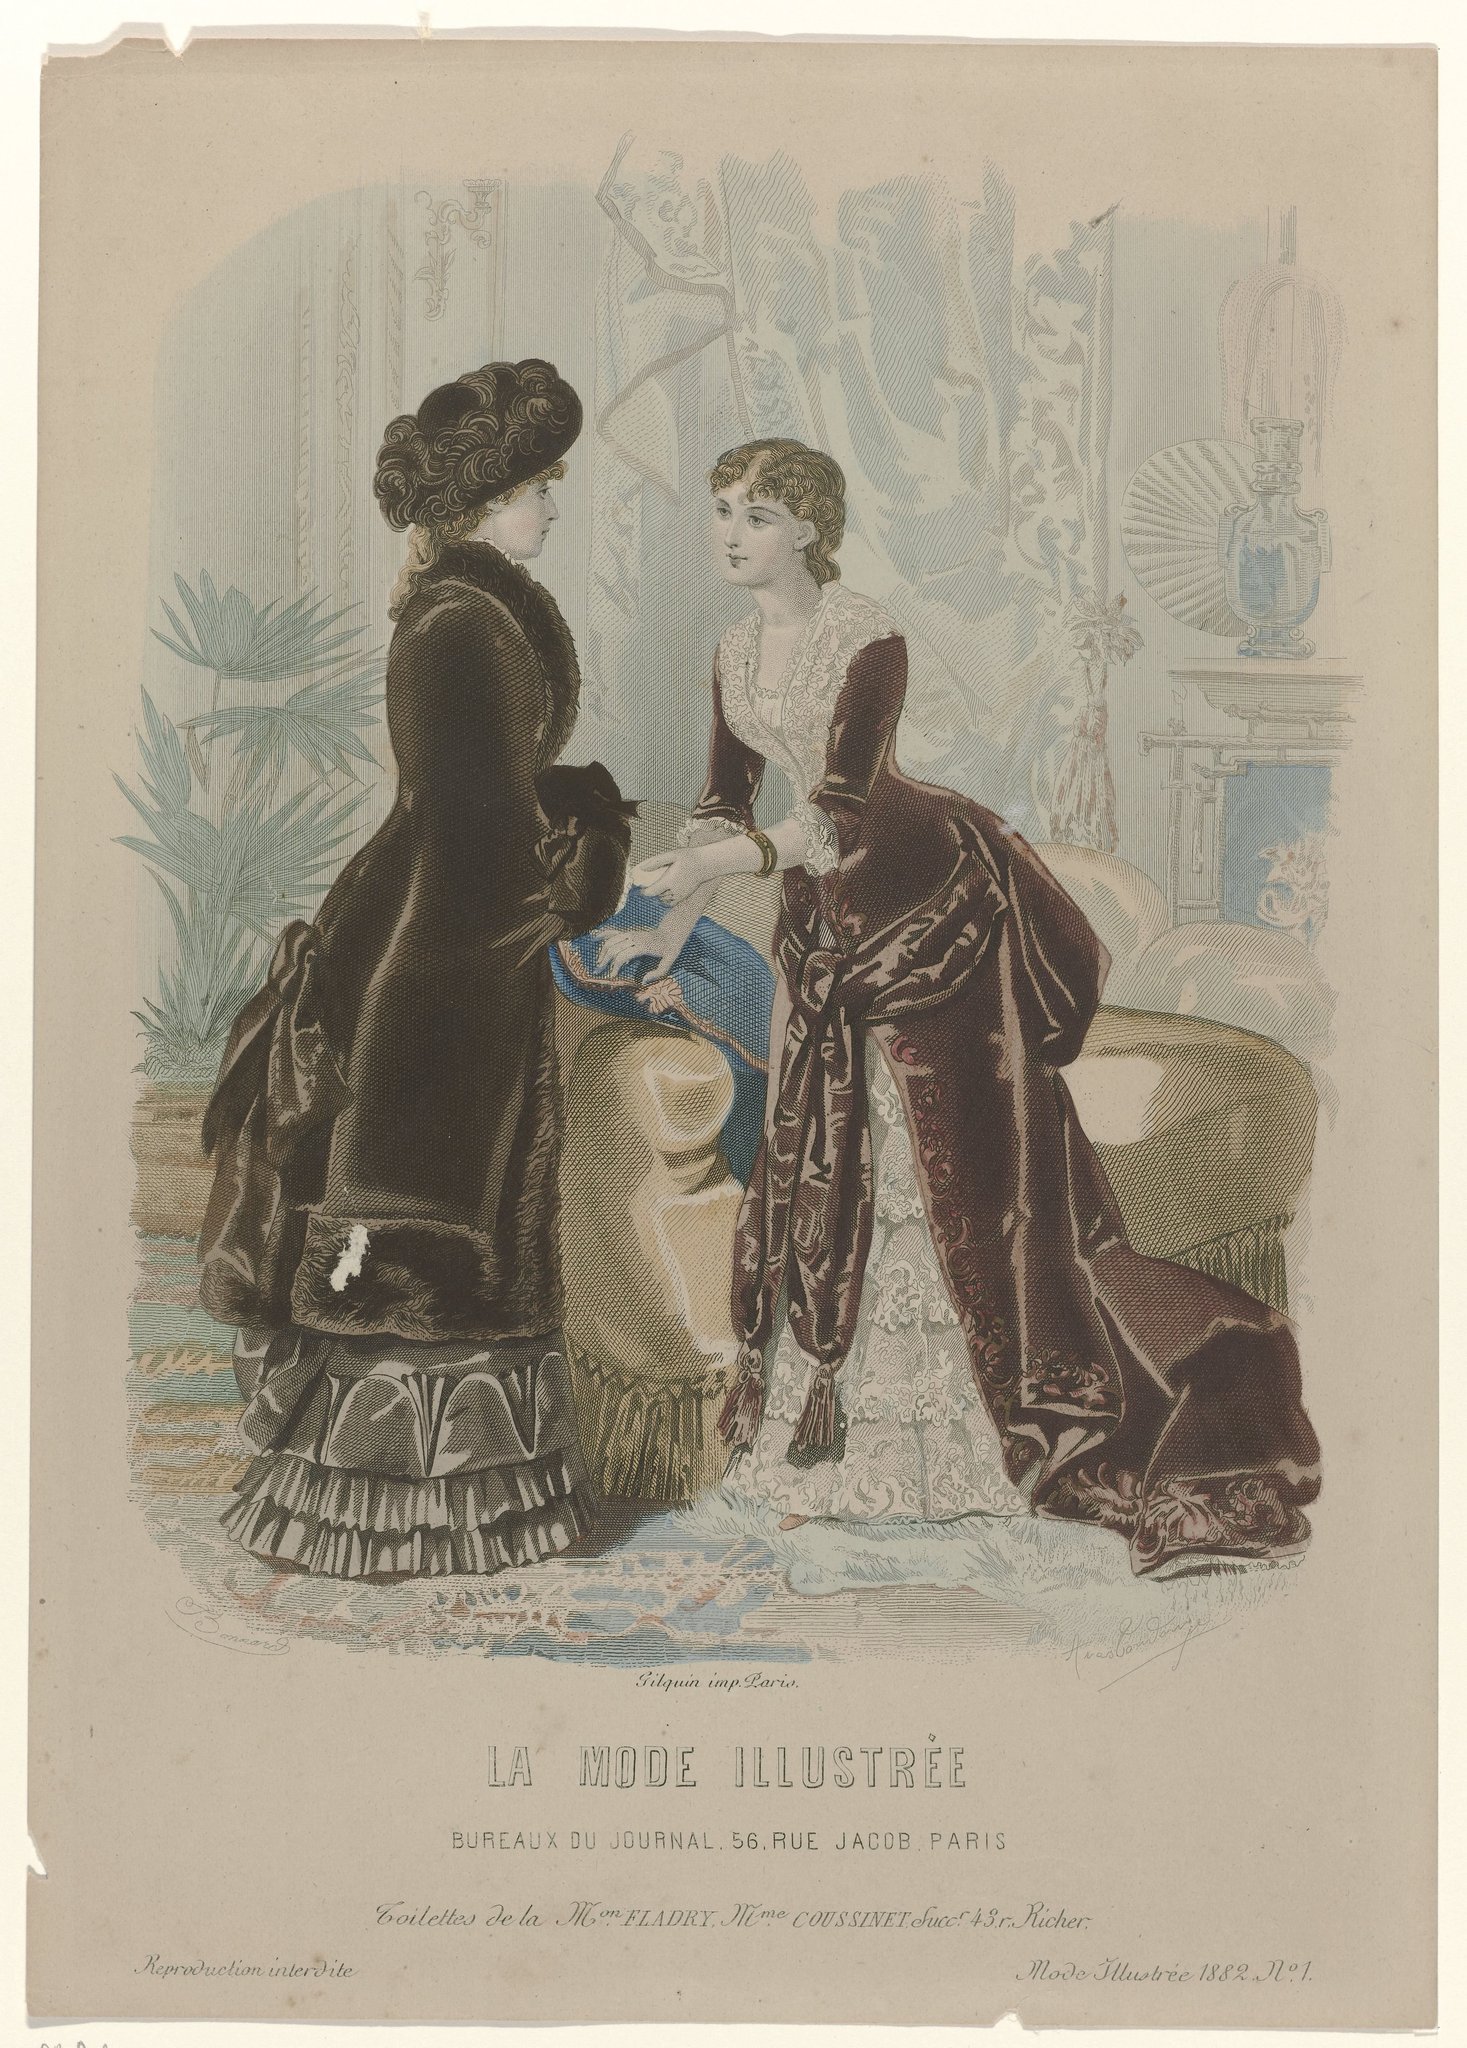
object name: fashion print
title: La Mode Illustrée, Journal de la Famille, dimanche 1 janvier 1882, No. 1: Toilettes de la M.on Fladry (...)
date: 1882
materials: paper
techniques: engraving, hand coloring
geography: paris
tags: clothing for the upper part of the body (shawl) (+ women's clothes), border, ribbon, braid (+ fur used for clothes), dress, gown: dinner dress (+ women's clothes), coat (+ women's clothes), fashion plates, head-gear: hat (+ women's clothes), skirt (+ women's clothes), bracelet, wristlet (+ women's clothes)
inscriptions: title: ‘La Mode Illustrée’, caption: ‘Toilettes de la M.on Fladry, M.me Cousssinet Succ.r 43.r. Richer.’, address: ‘Bureaux du Journal, 56, Rue Jacob, Paris’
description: Twee vrouwen in een interieur. Links: 'toilette de ville'. Rok en lijfje van 'peluche' in verschillende tinten bruin. 'Grande visite' van bruin 'peluche' afgezet met bont. Rechts: 'toilette de diner' van 'moire' en 'velours nacarat' (rood?). Twee sjaals gestrikt aan de voorkant. Volgens het onderschrift: 'toilettes' van Maison Fladry, opvolger van Coussinet. Prent uit het modetijdschrift La Mode Illustrée (1860-1937). Uitgebreide beschrijving van de kleding op pagina 6 "DESCRIPTION DE TOILETTES".